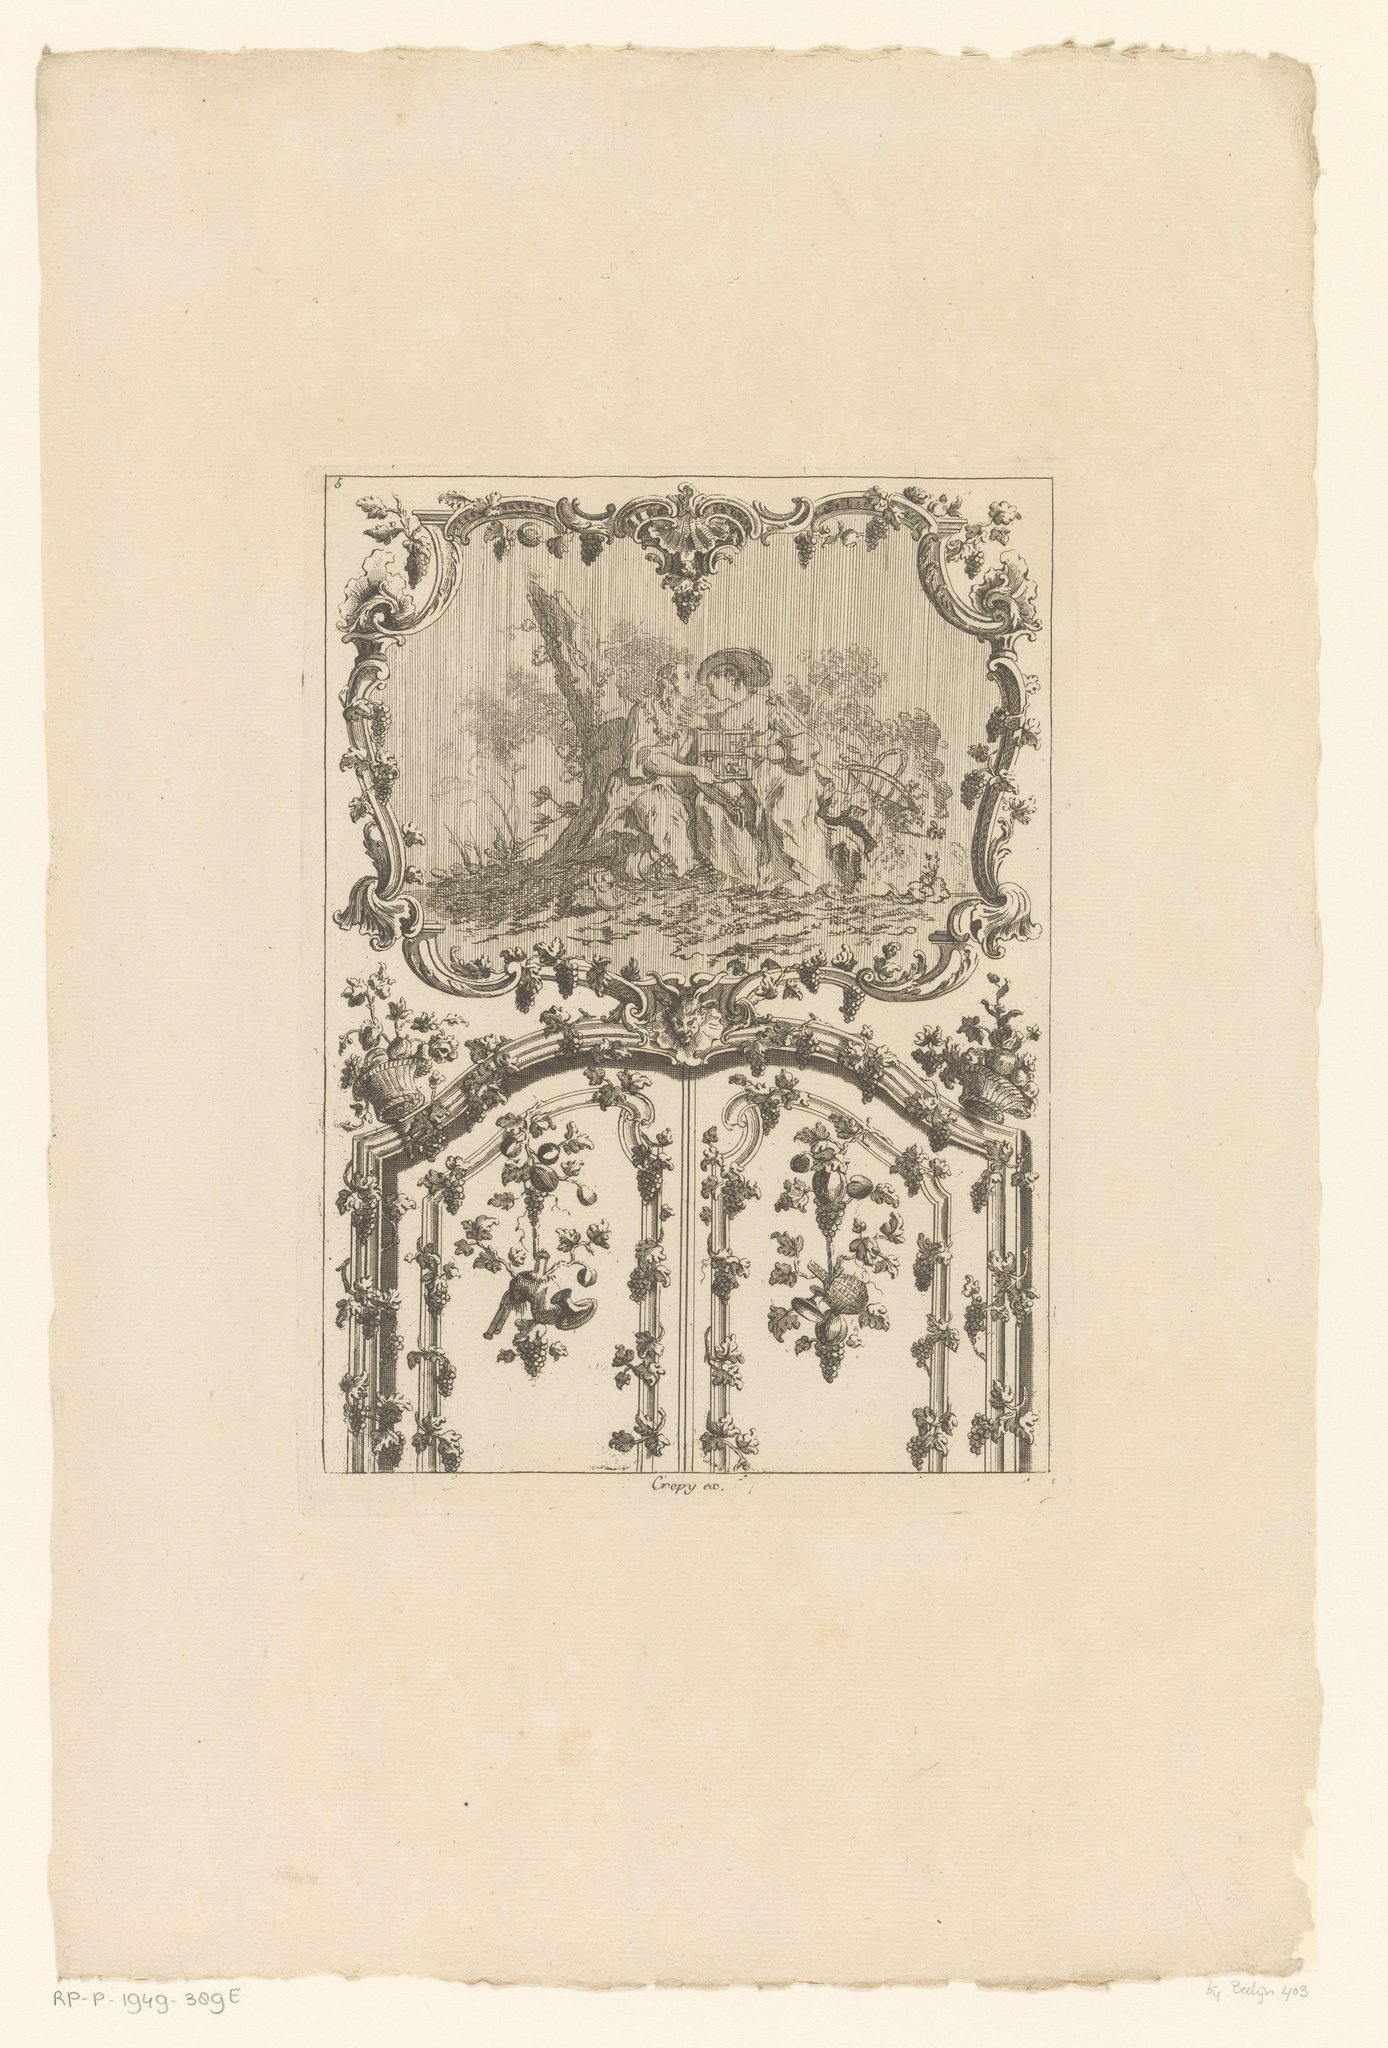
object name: ornament print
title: Neuvieme Livre D'Ornemens Propre pour la Menuiserie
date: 1749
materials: paper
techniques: engraving, etching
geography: paris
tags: door, couple of lovers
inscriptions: collector's mark: Lugt 2228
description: Een dessus-de-porte met afbeelding van een verliefd stel zittend met een vogelkooi in een landschap. Daaronder de bovenzijde van de deur met wijnranken en trofeeën.